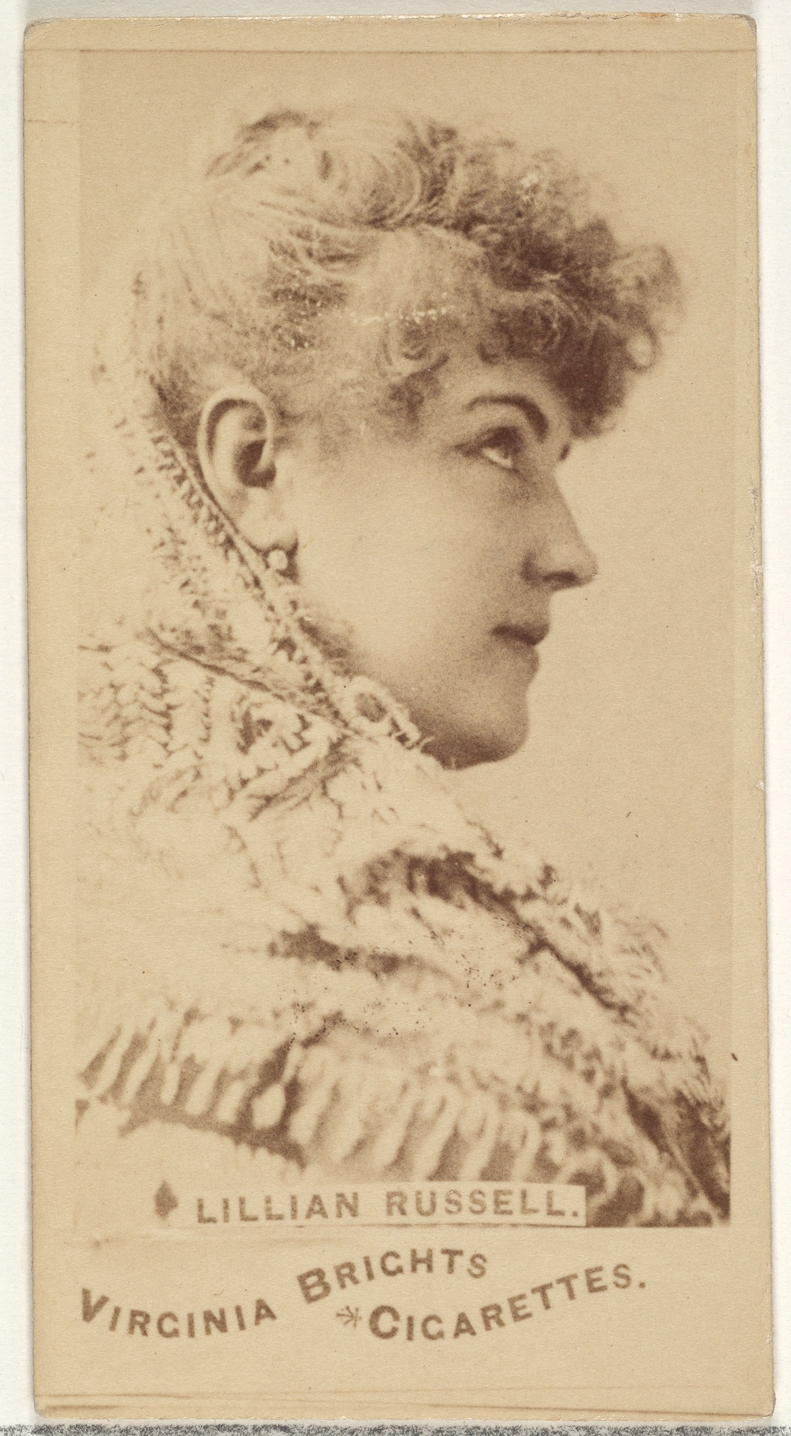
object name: photograph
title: Lillian Russell, from the Actors and Actresses series (N45, Type 1) for Virginia Brights Cigarettes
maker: allen & ginter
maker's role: publisher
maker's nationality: american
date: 1888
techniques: albumen silver print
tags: portraits,women,actresses